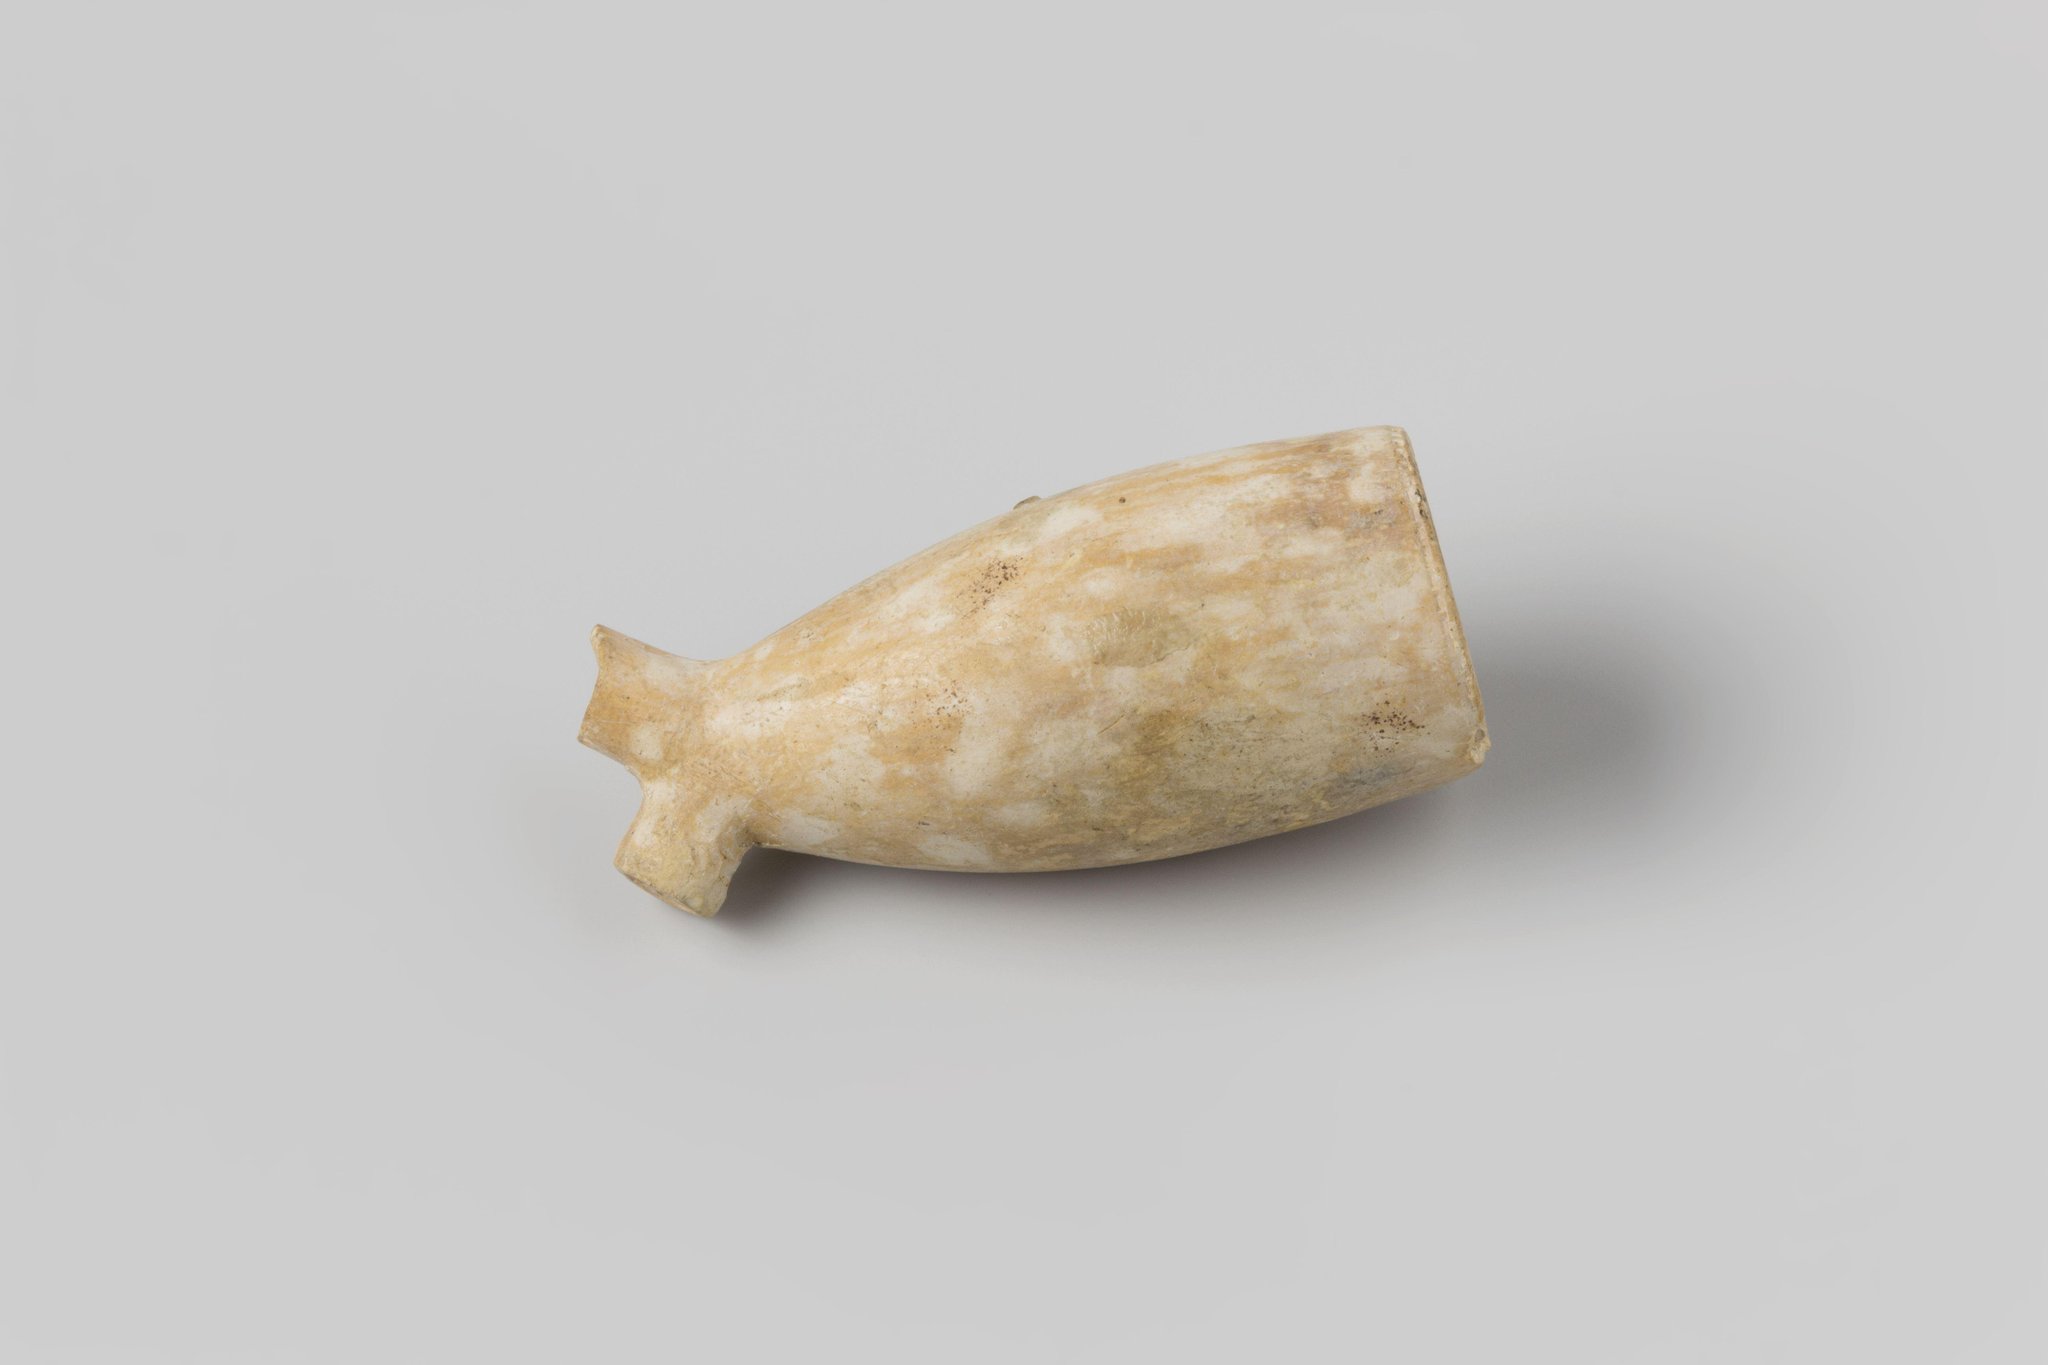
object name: pipe bowl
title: Pijpenkop uit het wrak van de Oost-Indiëvaarder Hollandia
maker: Anonymous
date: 1700-1743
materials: clay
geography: netherlands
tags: verenigde oostindische compagnie, hollandia (schip), annet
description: Pipe, bowl, heelmark: tobacco's brazier; no hsm.